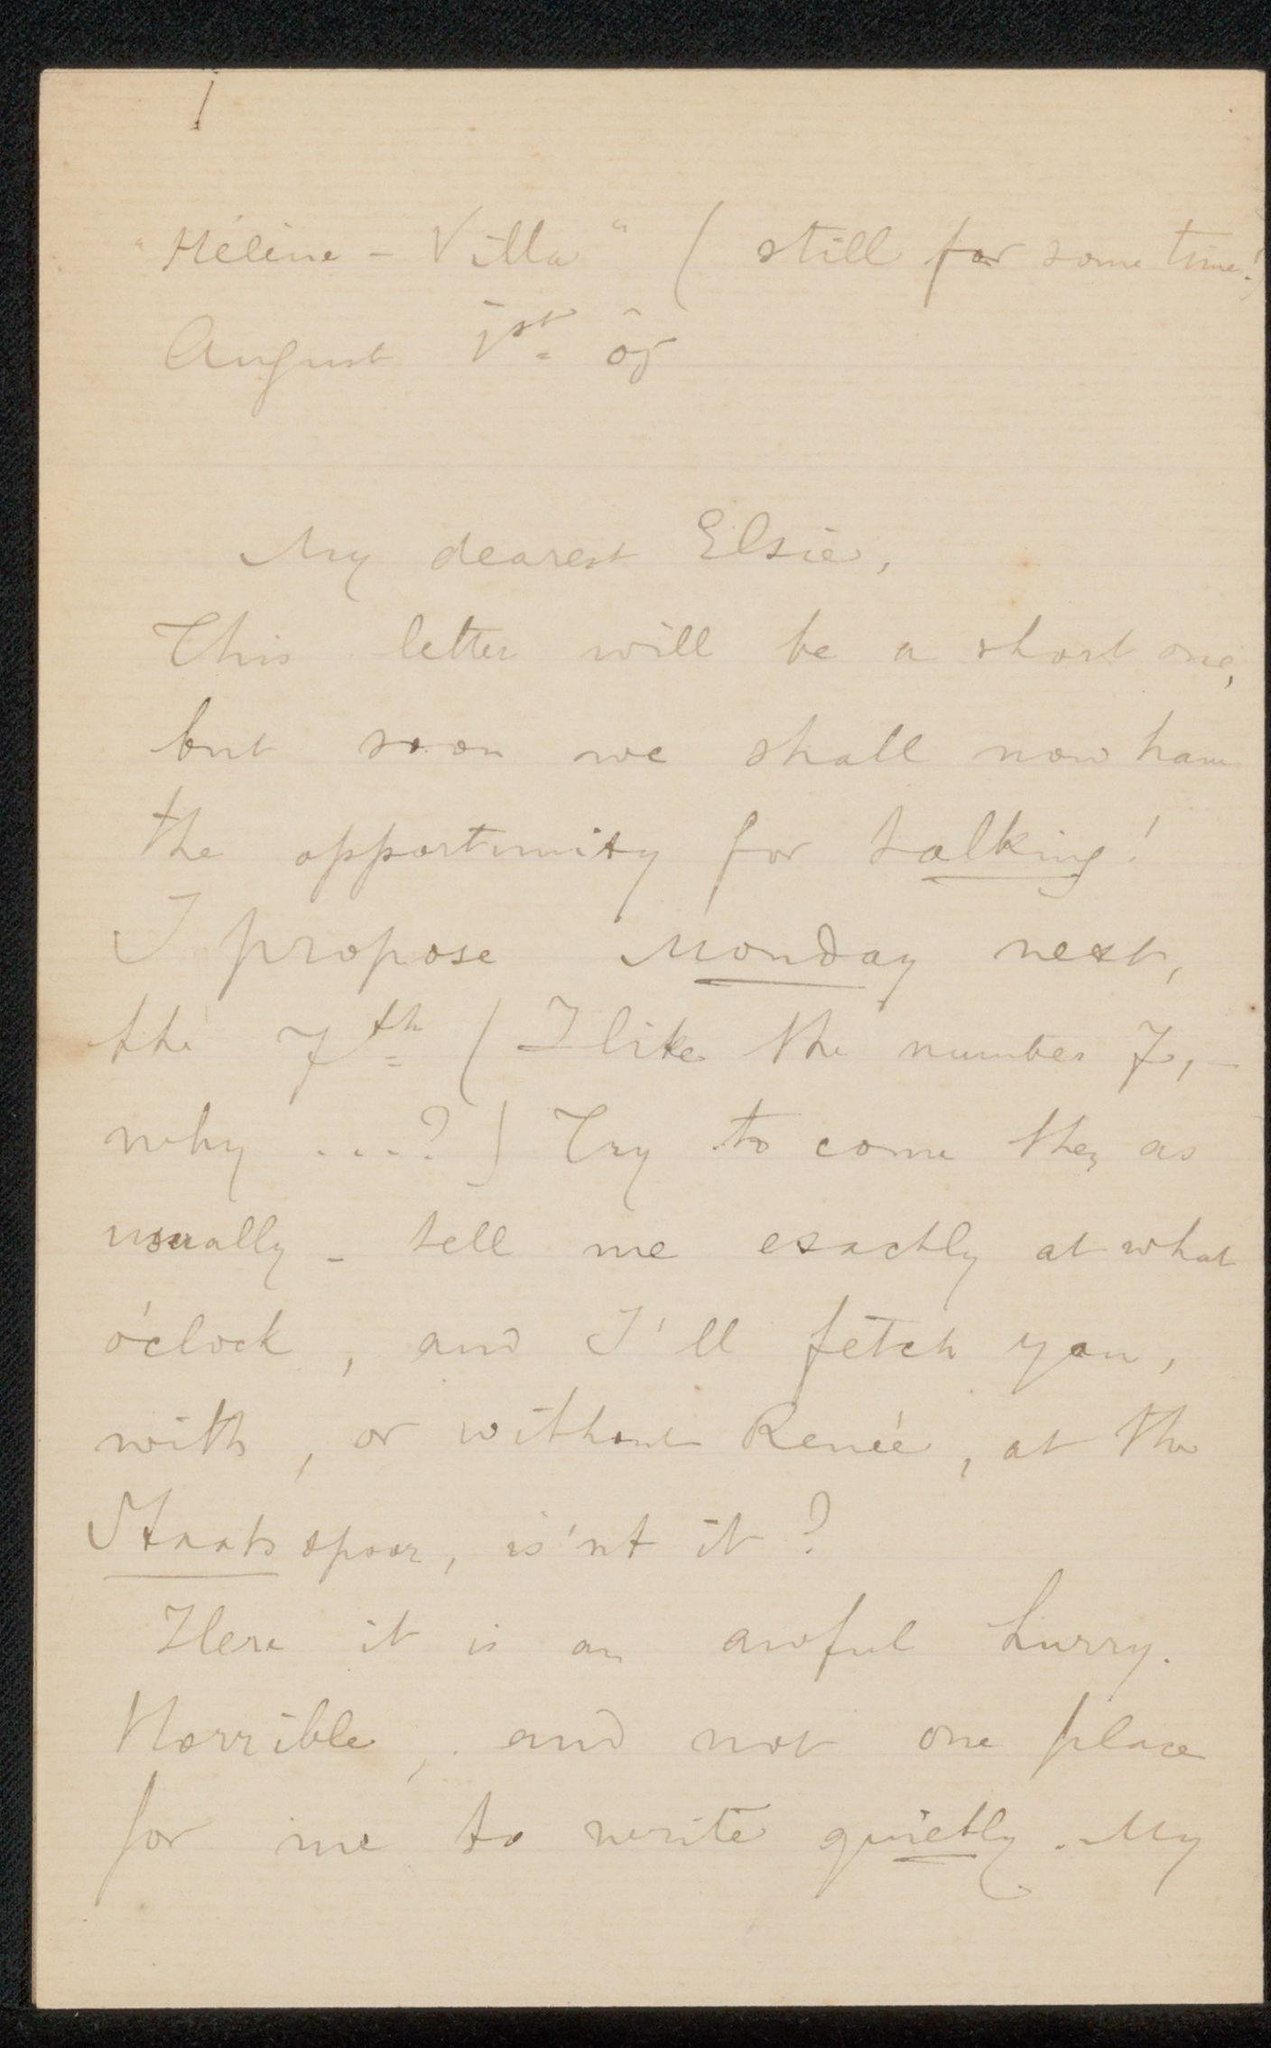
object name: letter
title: Brief aan Elsie Maud Cownie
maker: philip zilcken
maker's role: draughtsman, painter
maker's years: 1857-1930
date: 1905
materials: ink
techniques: pen, writing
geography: the hague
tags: manchester, elsie maud cownie, passions, emotions, affections, workshop, studio of the artist (in general)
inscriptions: watermark